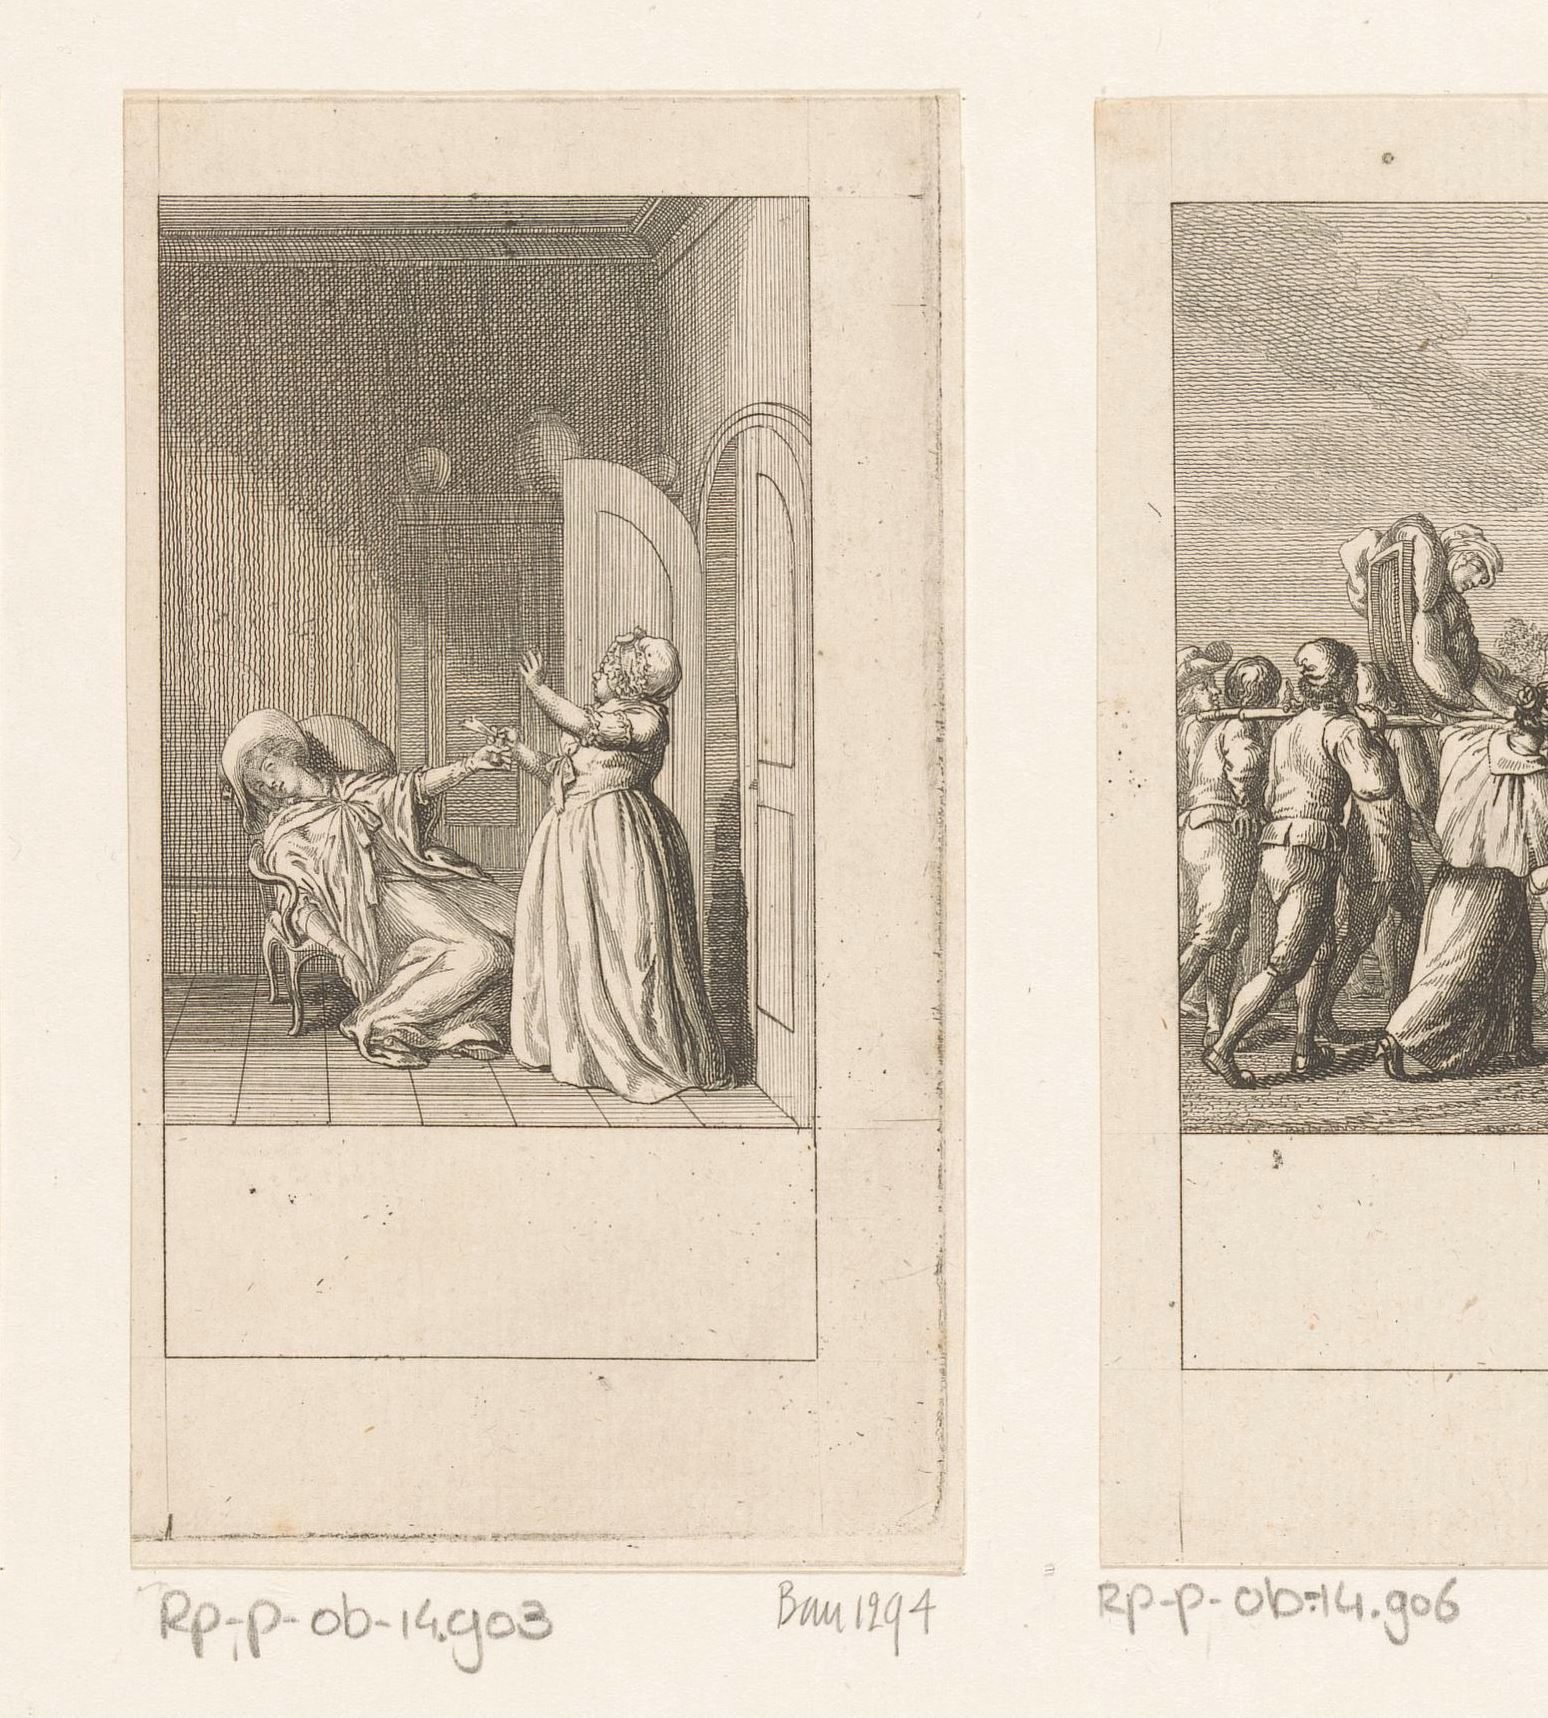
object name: print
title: Camille bekomt van de schrik van haar beroving terwijl een huismeid haar het medicijn brengt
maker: daniel nikolaus chodowiecki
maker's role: draughtsman, print maker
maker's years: 1726-1801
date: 1787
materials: paper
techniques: etching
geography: berlin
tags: fainting, swooning, open door, literature, interior of the house, arm stretched forward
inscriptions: collector's mark: Lugt 2228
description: Vervaardigd voor J. F. Jünger's vertaling van 'Camille: oder, Briefe zweyer Mädchen aus unserm Zeitalter'. Een latere staat gebruikt in: Genealogischer Taschenkalender. Auf das Jahr 1788. Berlijn: Königl. Academie der Wissenschaften, 1787.